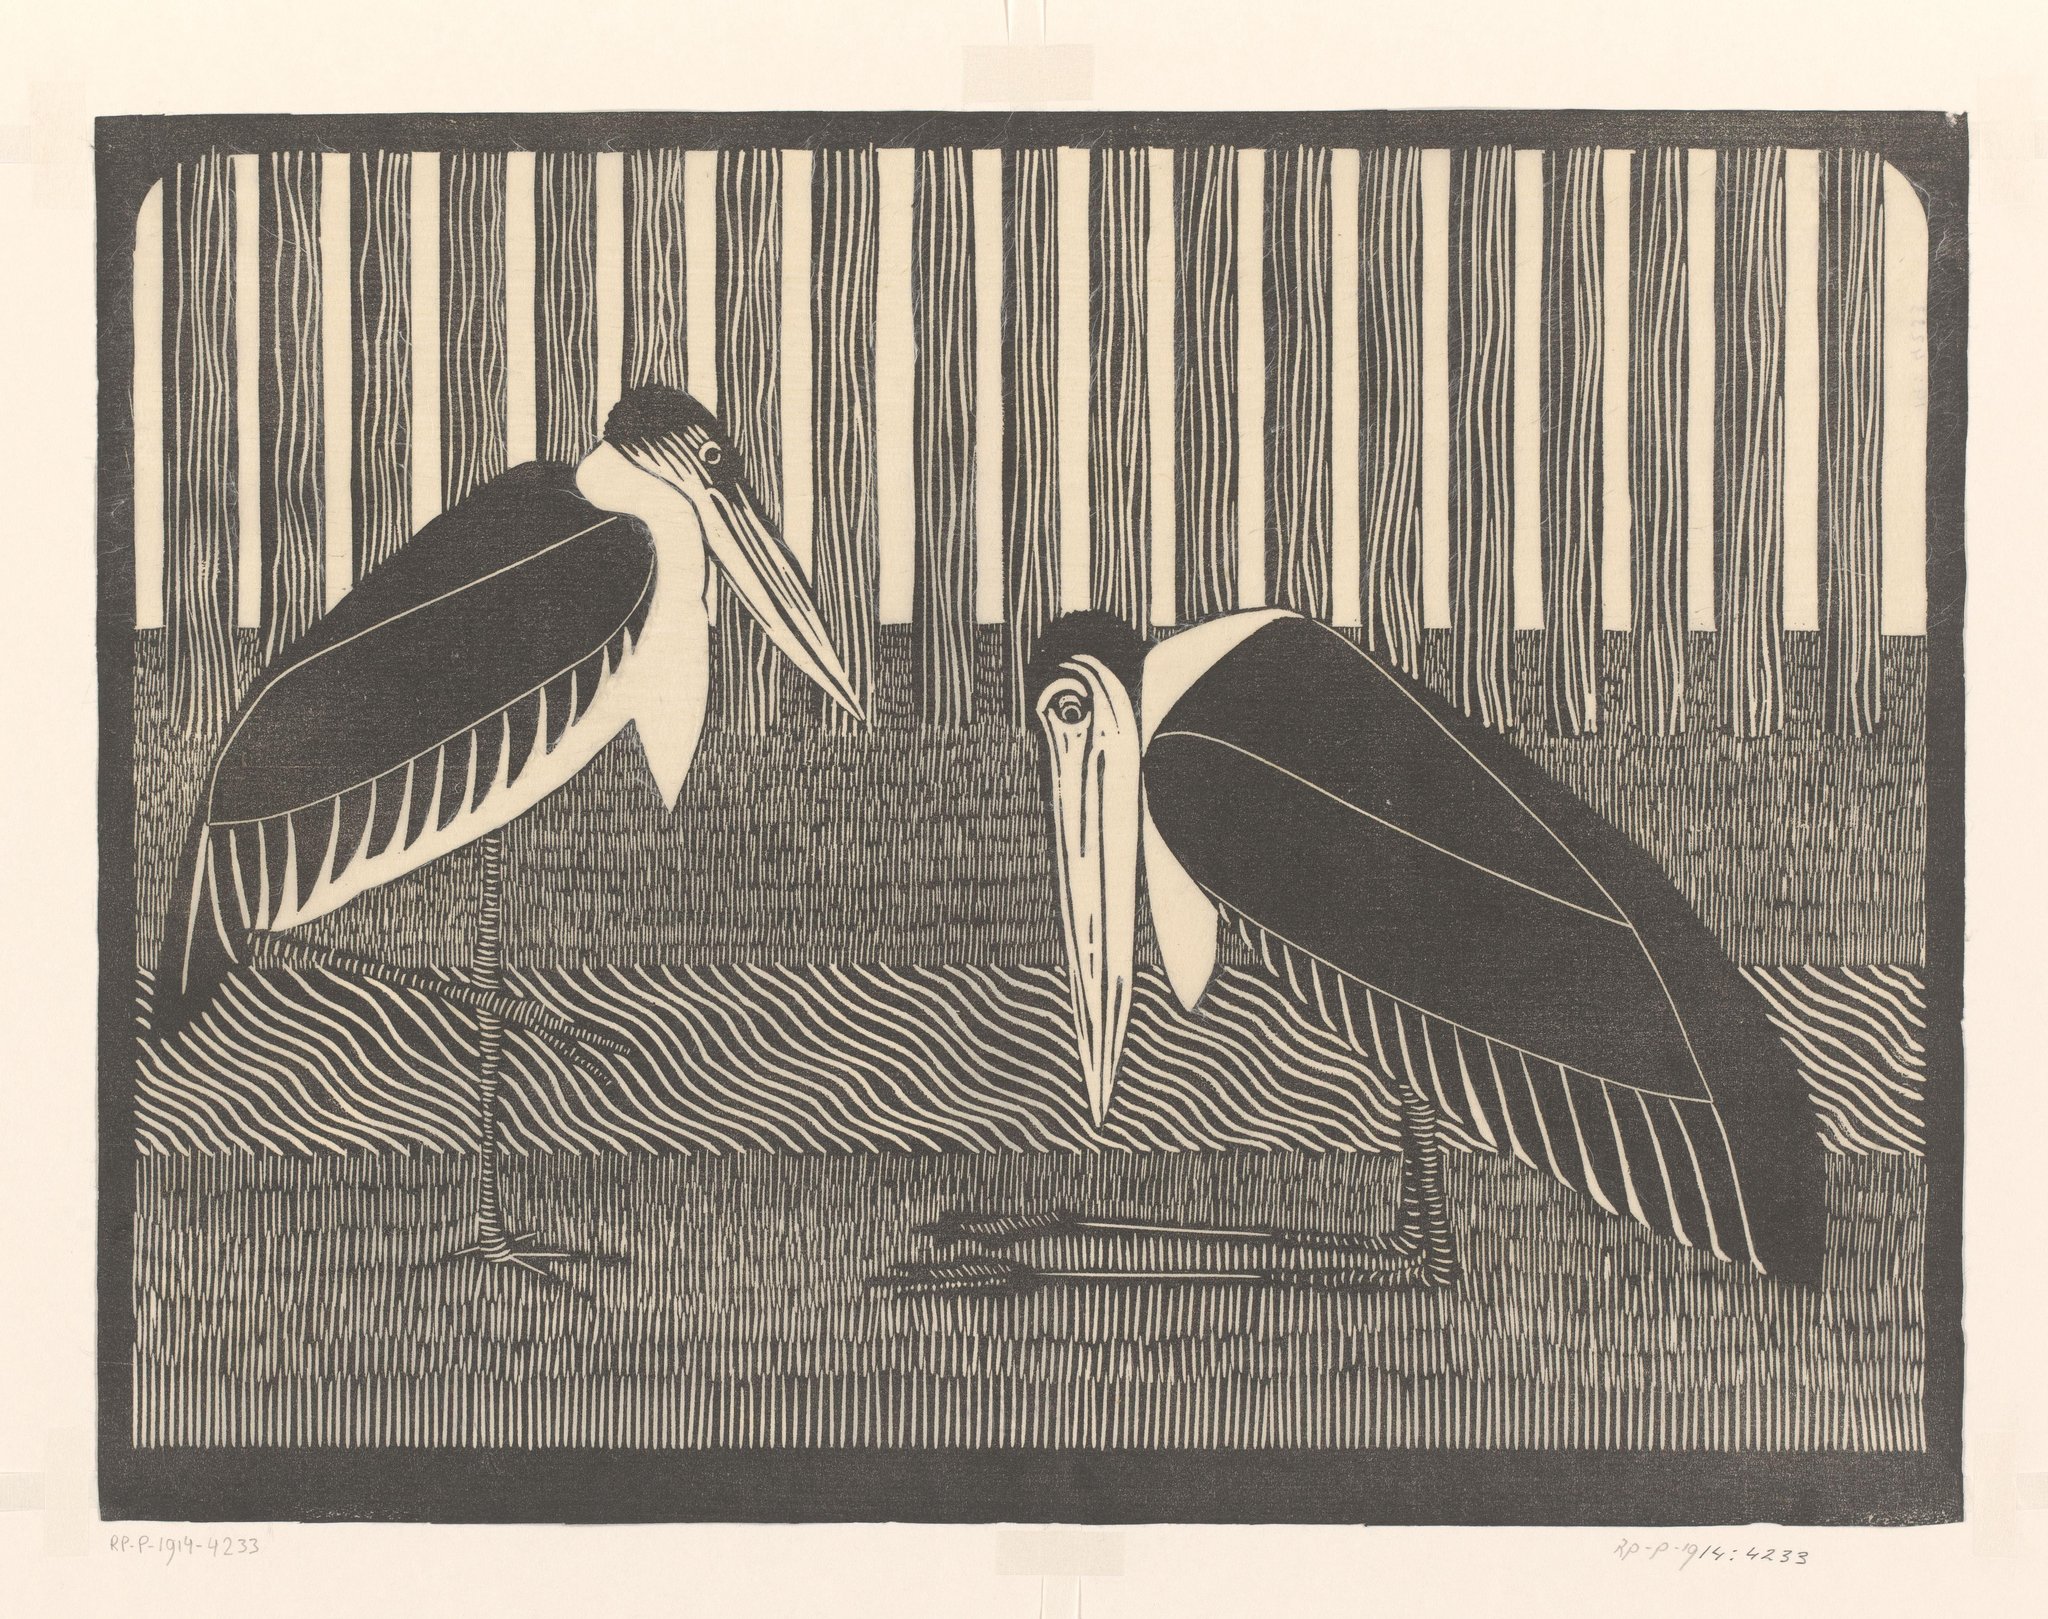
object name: print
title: Twee maraboes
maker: samuel jessurun de mesquita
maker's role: draughtsman, print maker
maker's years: 1868-1944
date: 1914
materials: paper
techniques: woodcut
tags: shore-birds and wading-birds: marabou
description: Links een maraboe op een poot; rechts een zittende maraboe. Op de achtergrond boomstammen.